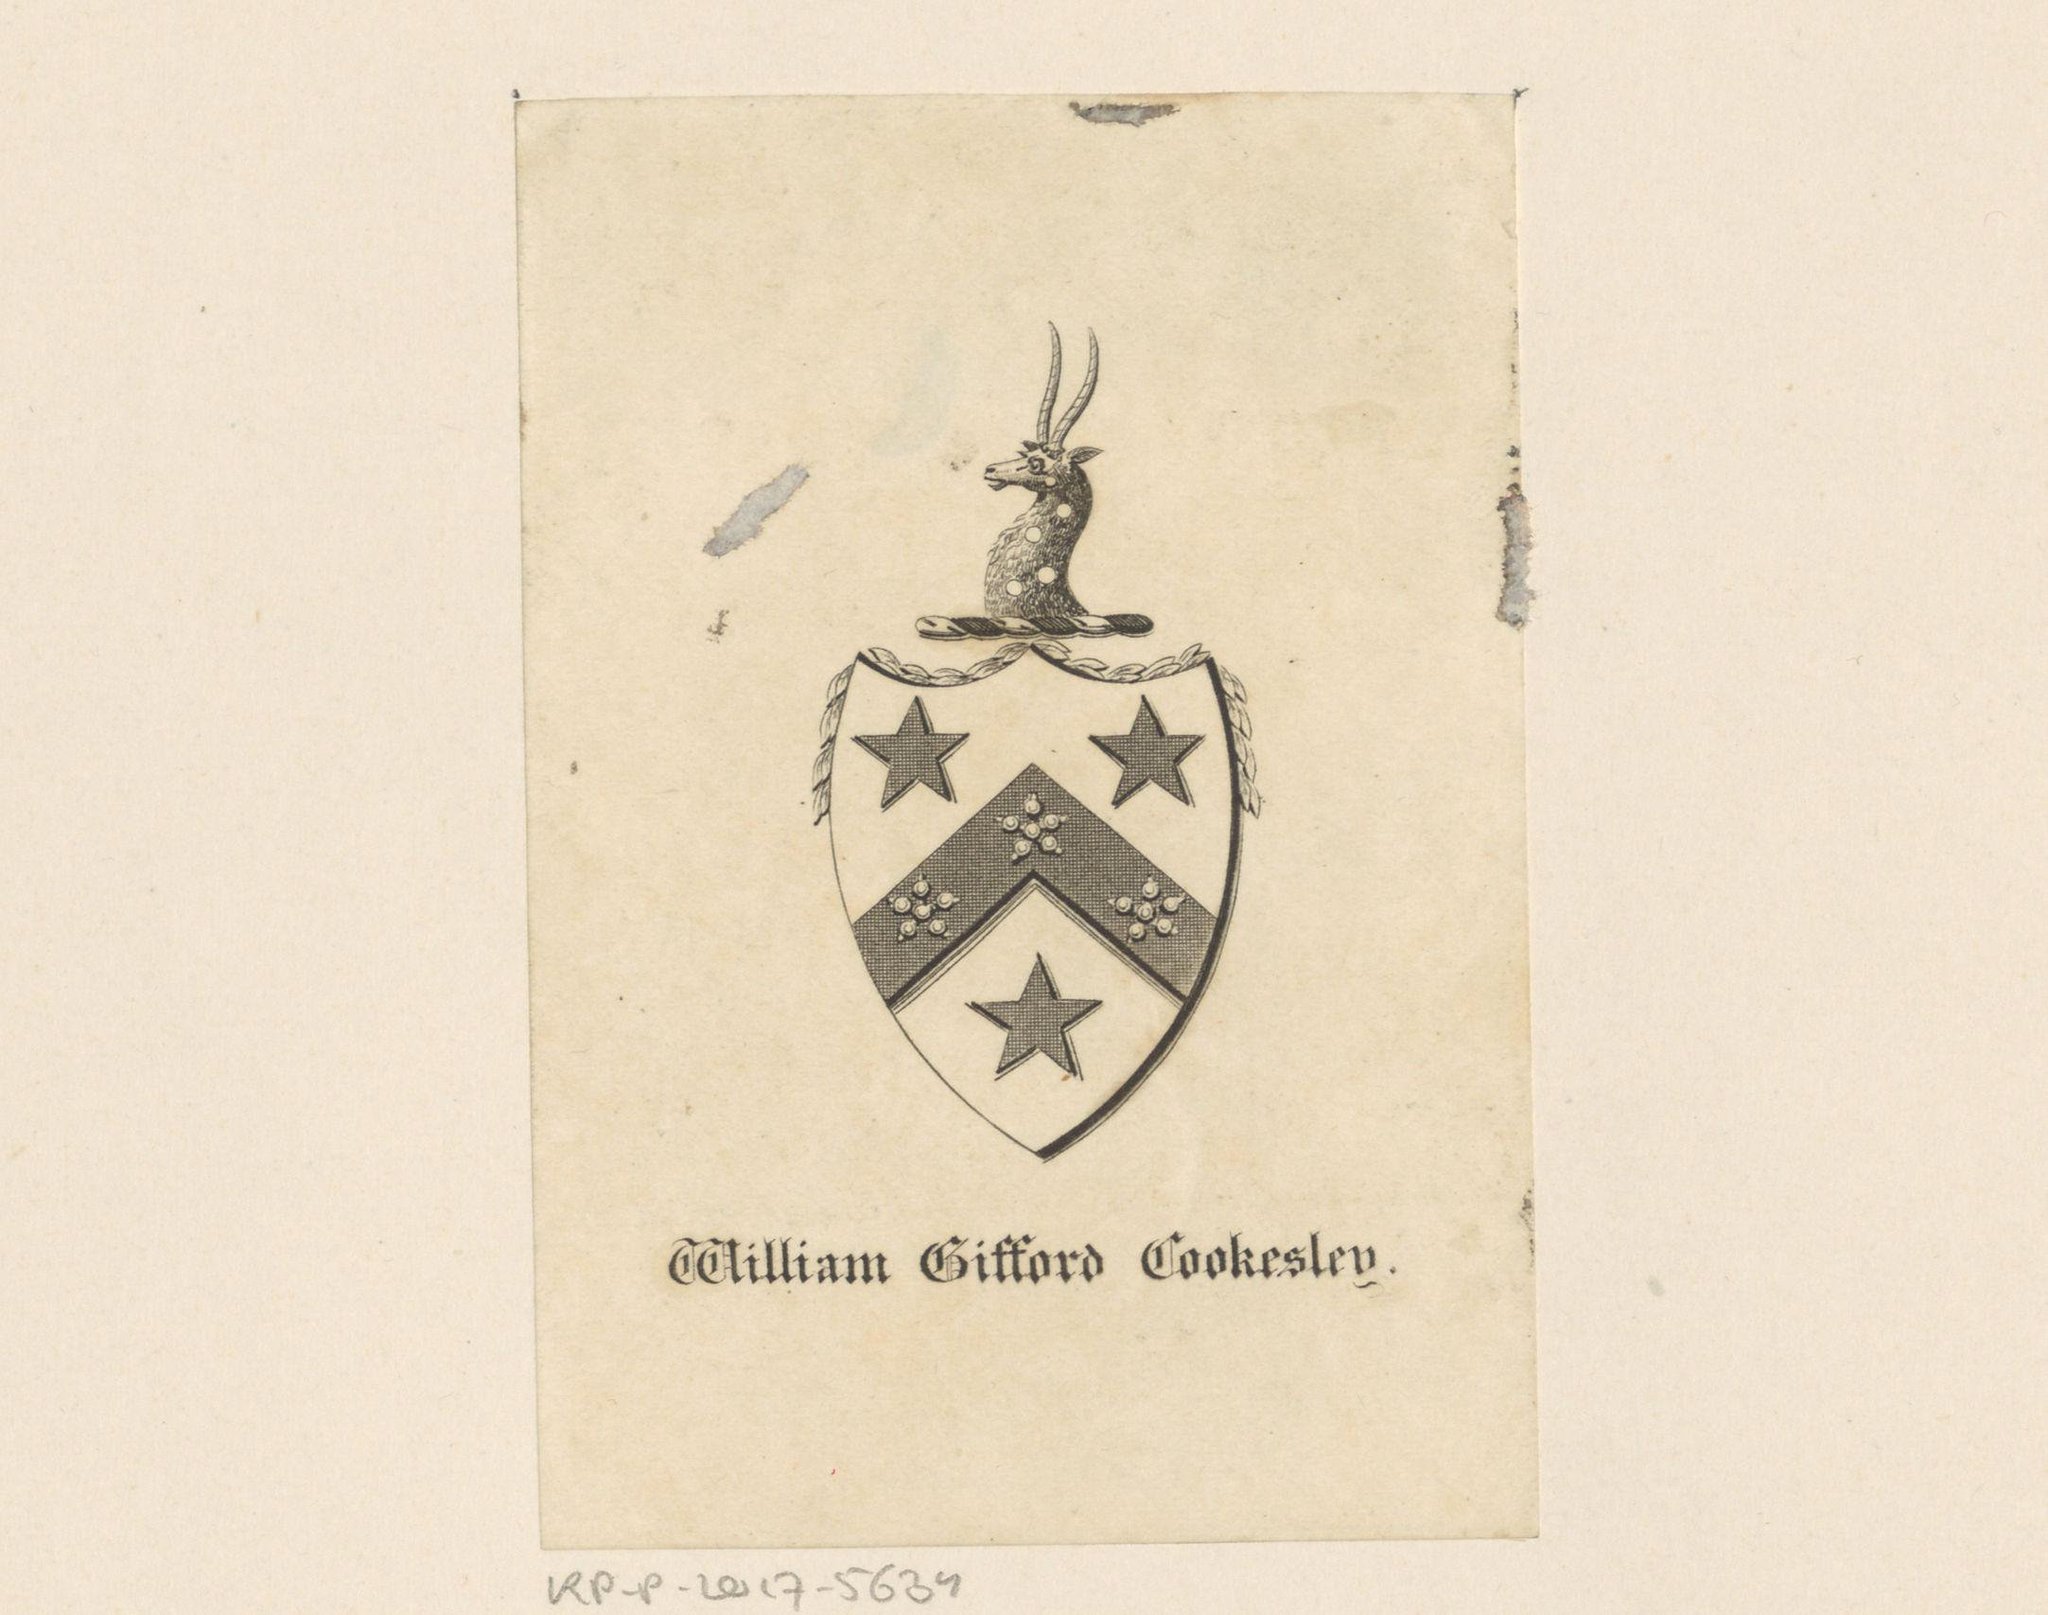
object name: bookplate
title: Ex libris van William Gifford Cookesley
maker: Anonymous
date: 1810-1880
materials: paper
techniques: etching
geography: england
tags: ram, armorial bearing, heraldry